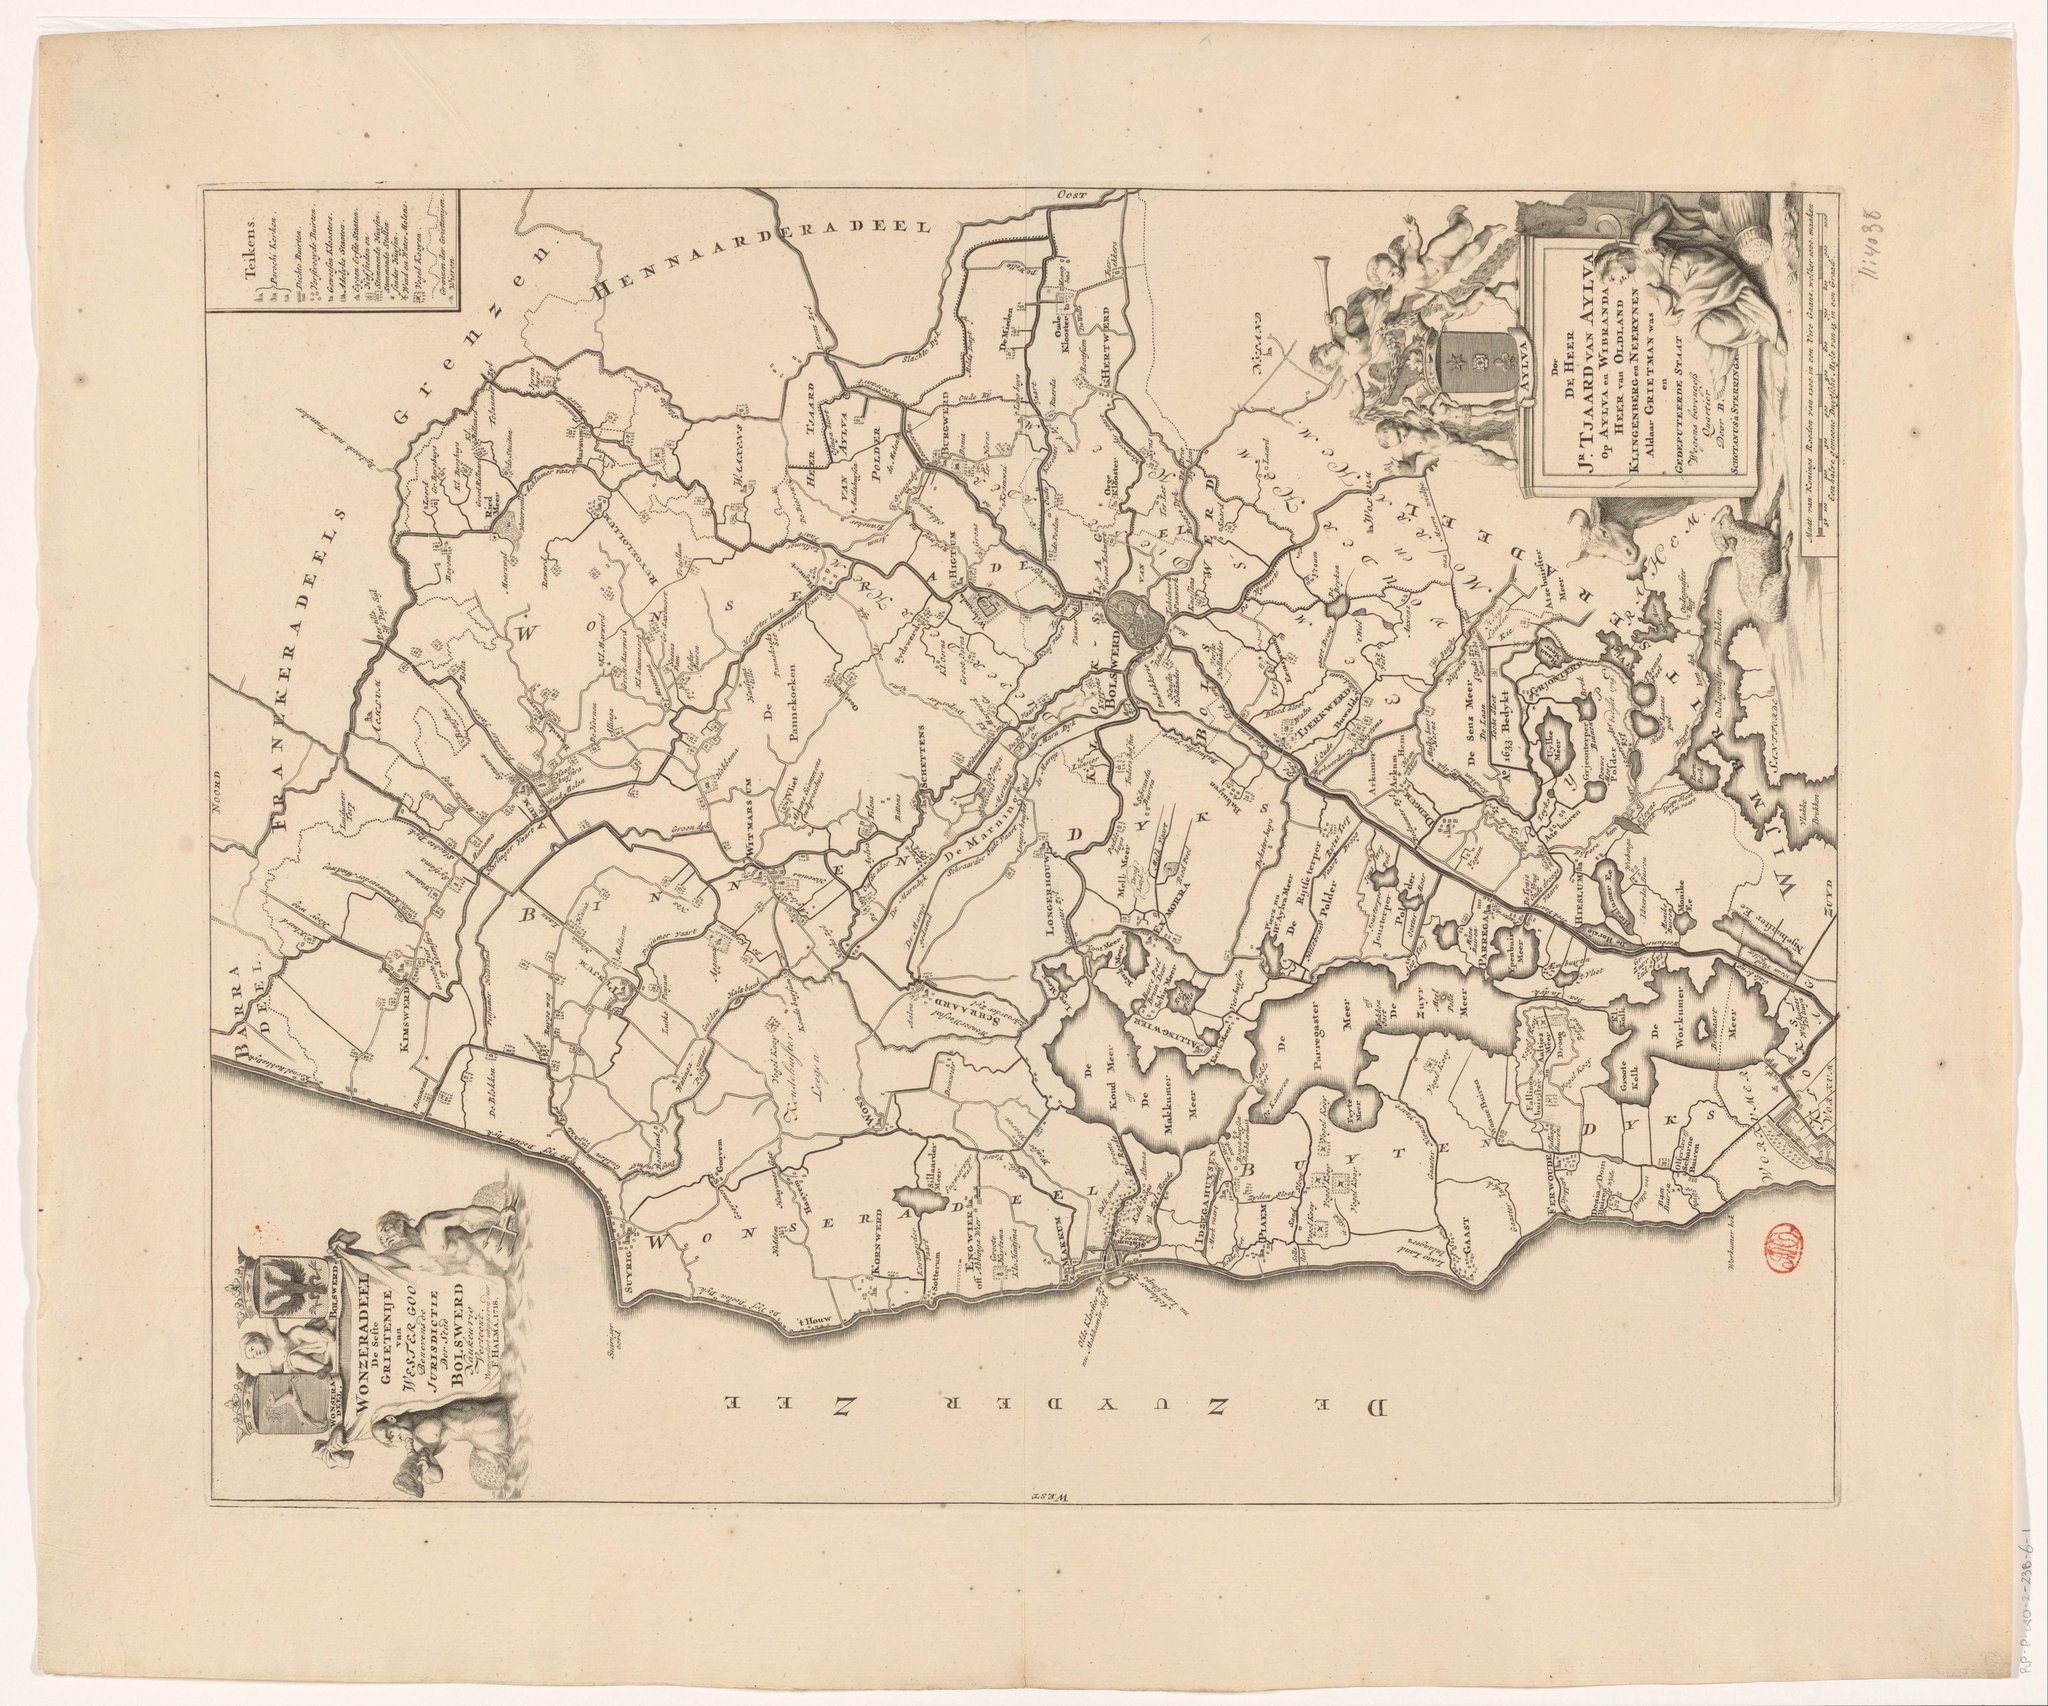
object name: print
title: Wonzeradeel de seste grietenije van Wester goo (...)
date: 1698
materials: paper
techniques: engraving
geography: amsterdam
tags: coat of arms (as symbol of the state, etc.), (story of) ceres (demeter), triton(s), maps of separate countries or regions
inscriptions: label: ‘264’, collector's mark: Lugt 195, collector's mark: Lugt 2228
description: Linksboven titelcartouche met de wapens van Wonseradeel en Bolsward, daaromheen twee tritons. Rechtsboven legenda, rechtsonder cartouche met bestuurlijke informatie over de grietenij, daaromheen het wapen van grietman jonker Tjaard van Aylva, drie putti, vee en Ceres. Daaronder een schaalstok: Maat van konings roeden van 1200 in een uire gaans, welker 1000 maaken een halve gemeene Duytsche myle van 15 in een graad.